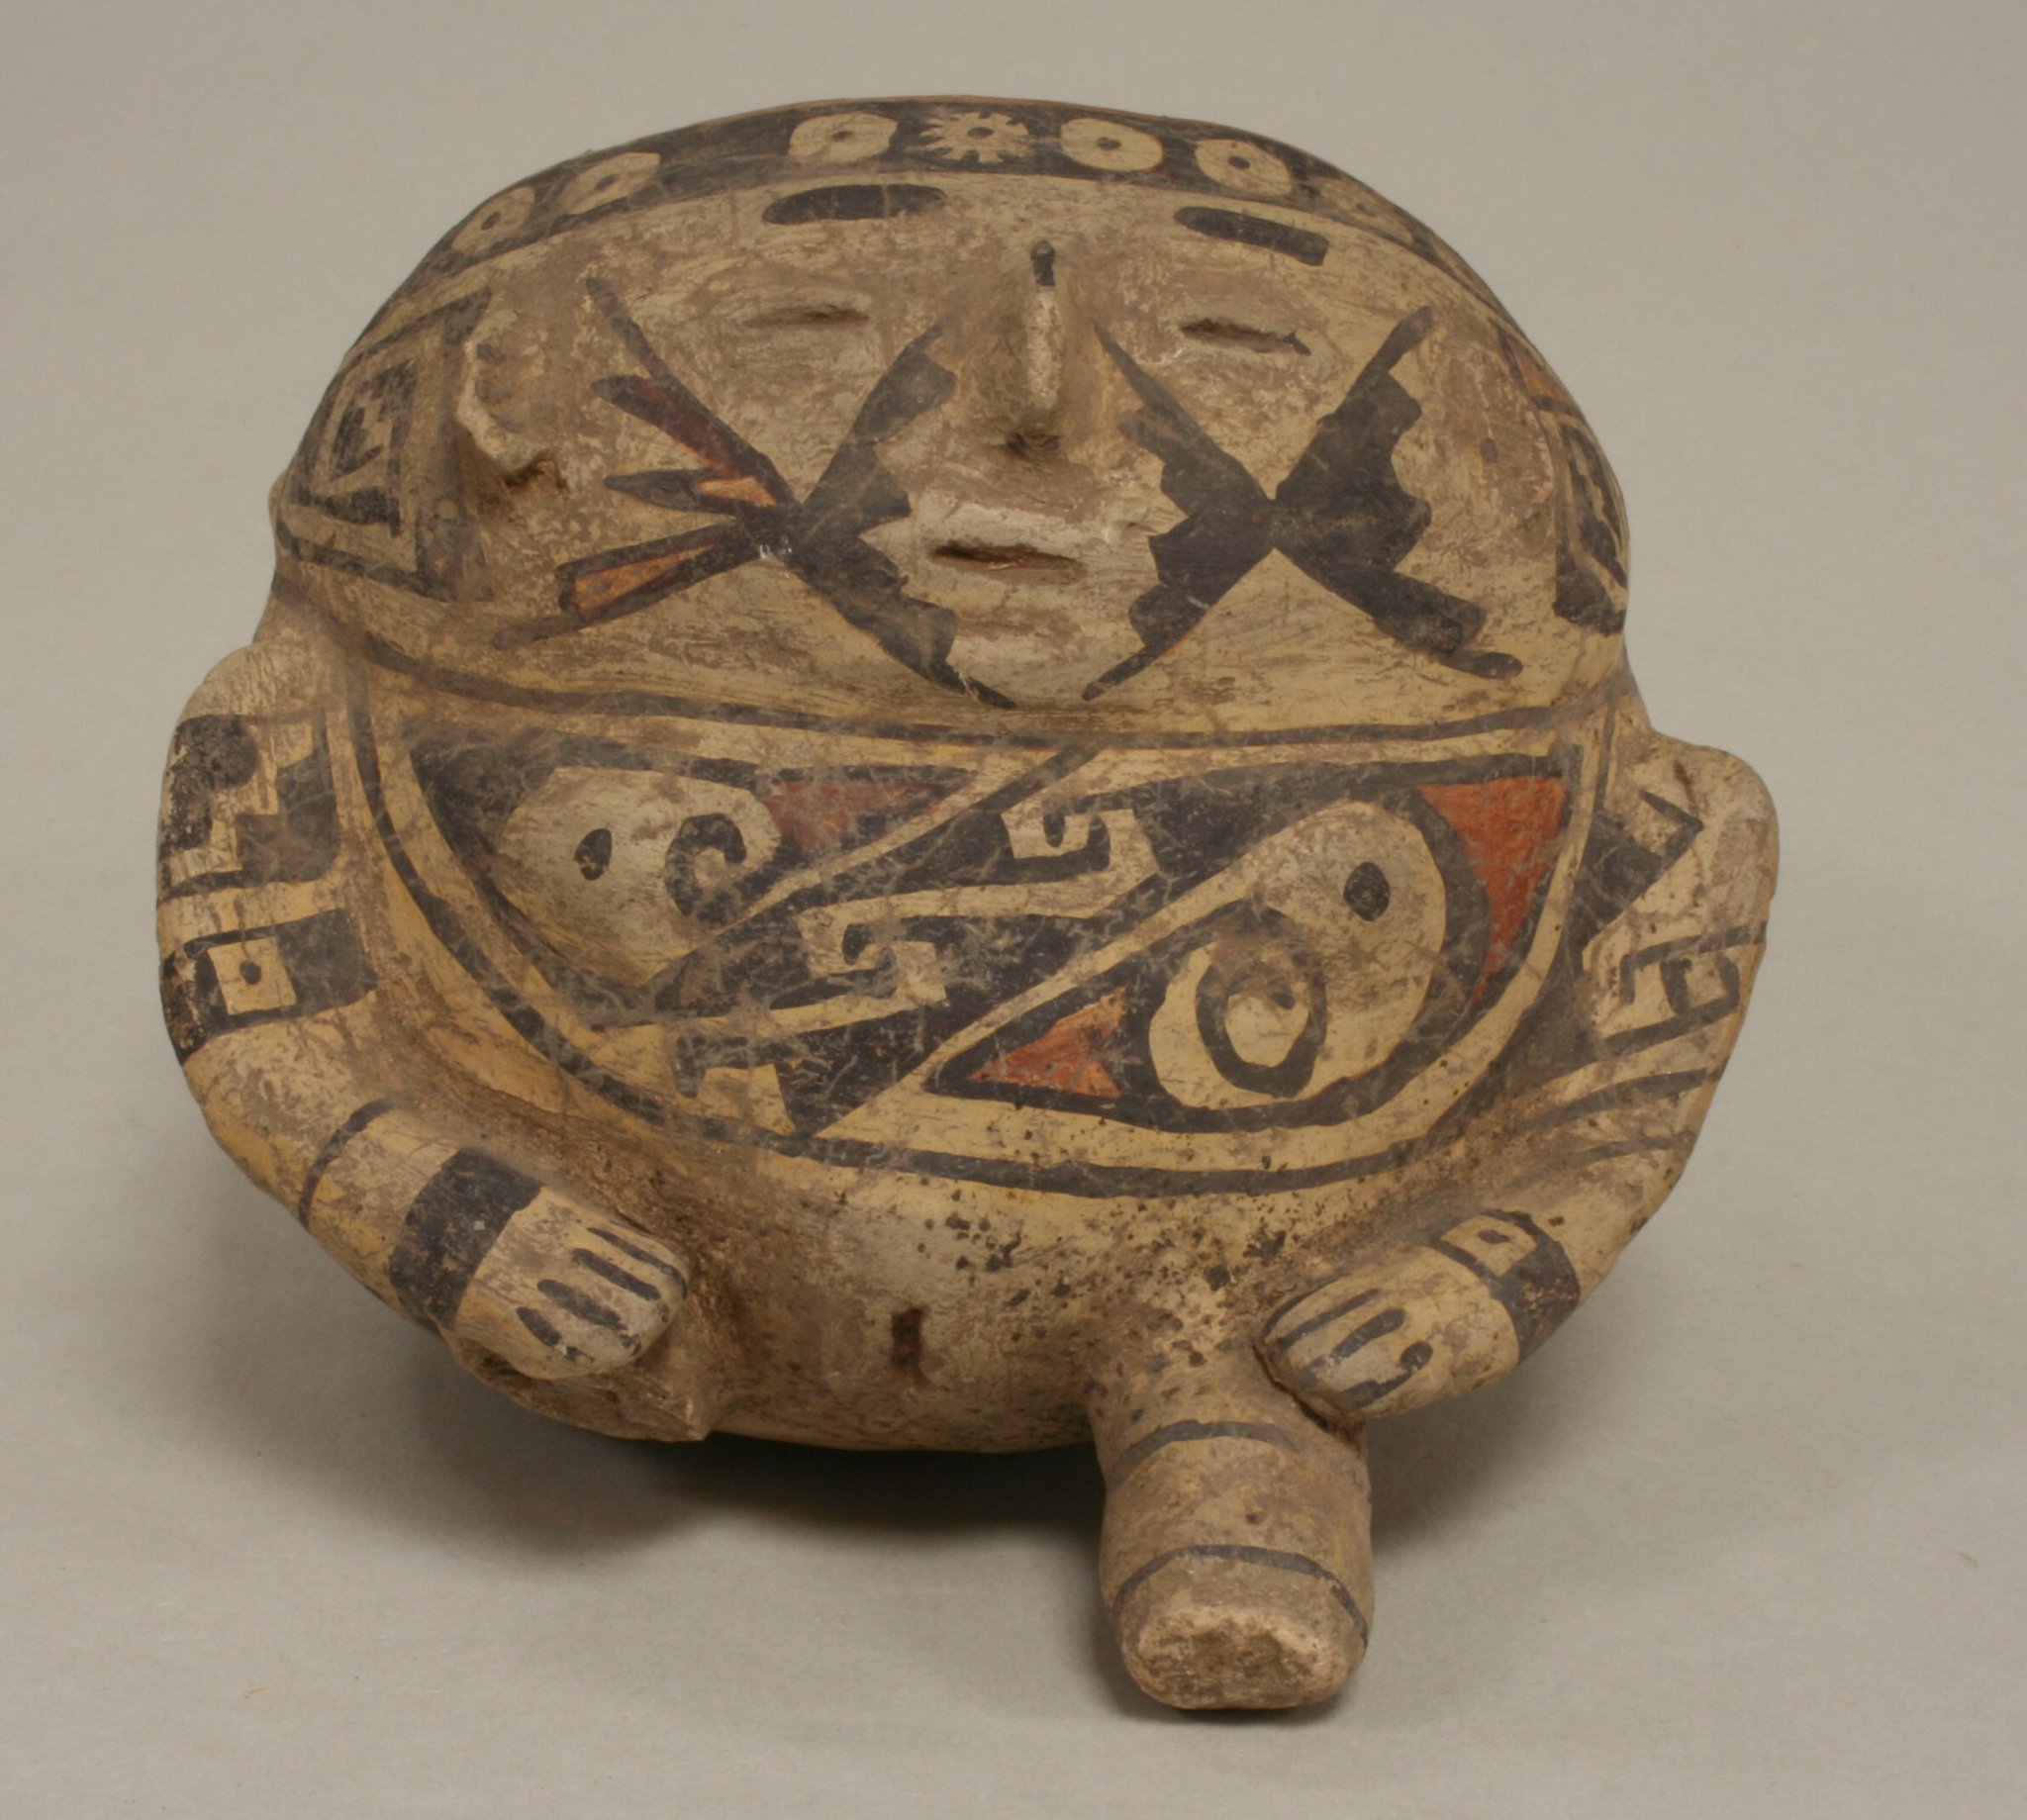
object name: vessel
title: Painted Vessel in the Form of a Seated Woman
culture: casas grandes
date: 301-400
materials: ceramic, pigment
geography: mexico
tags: women